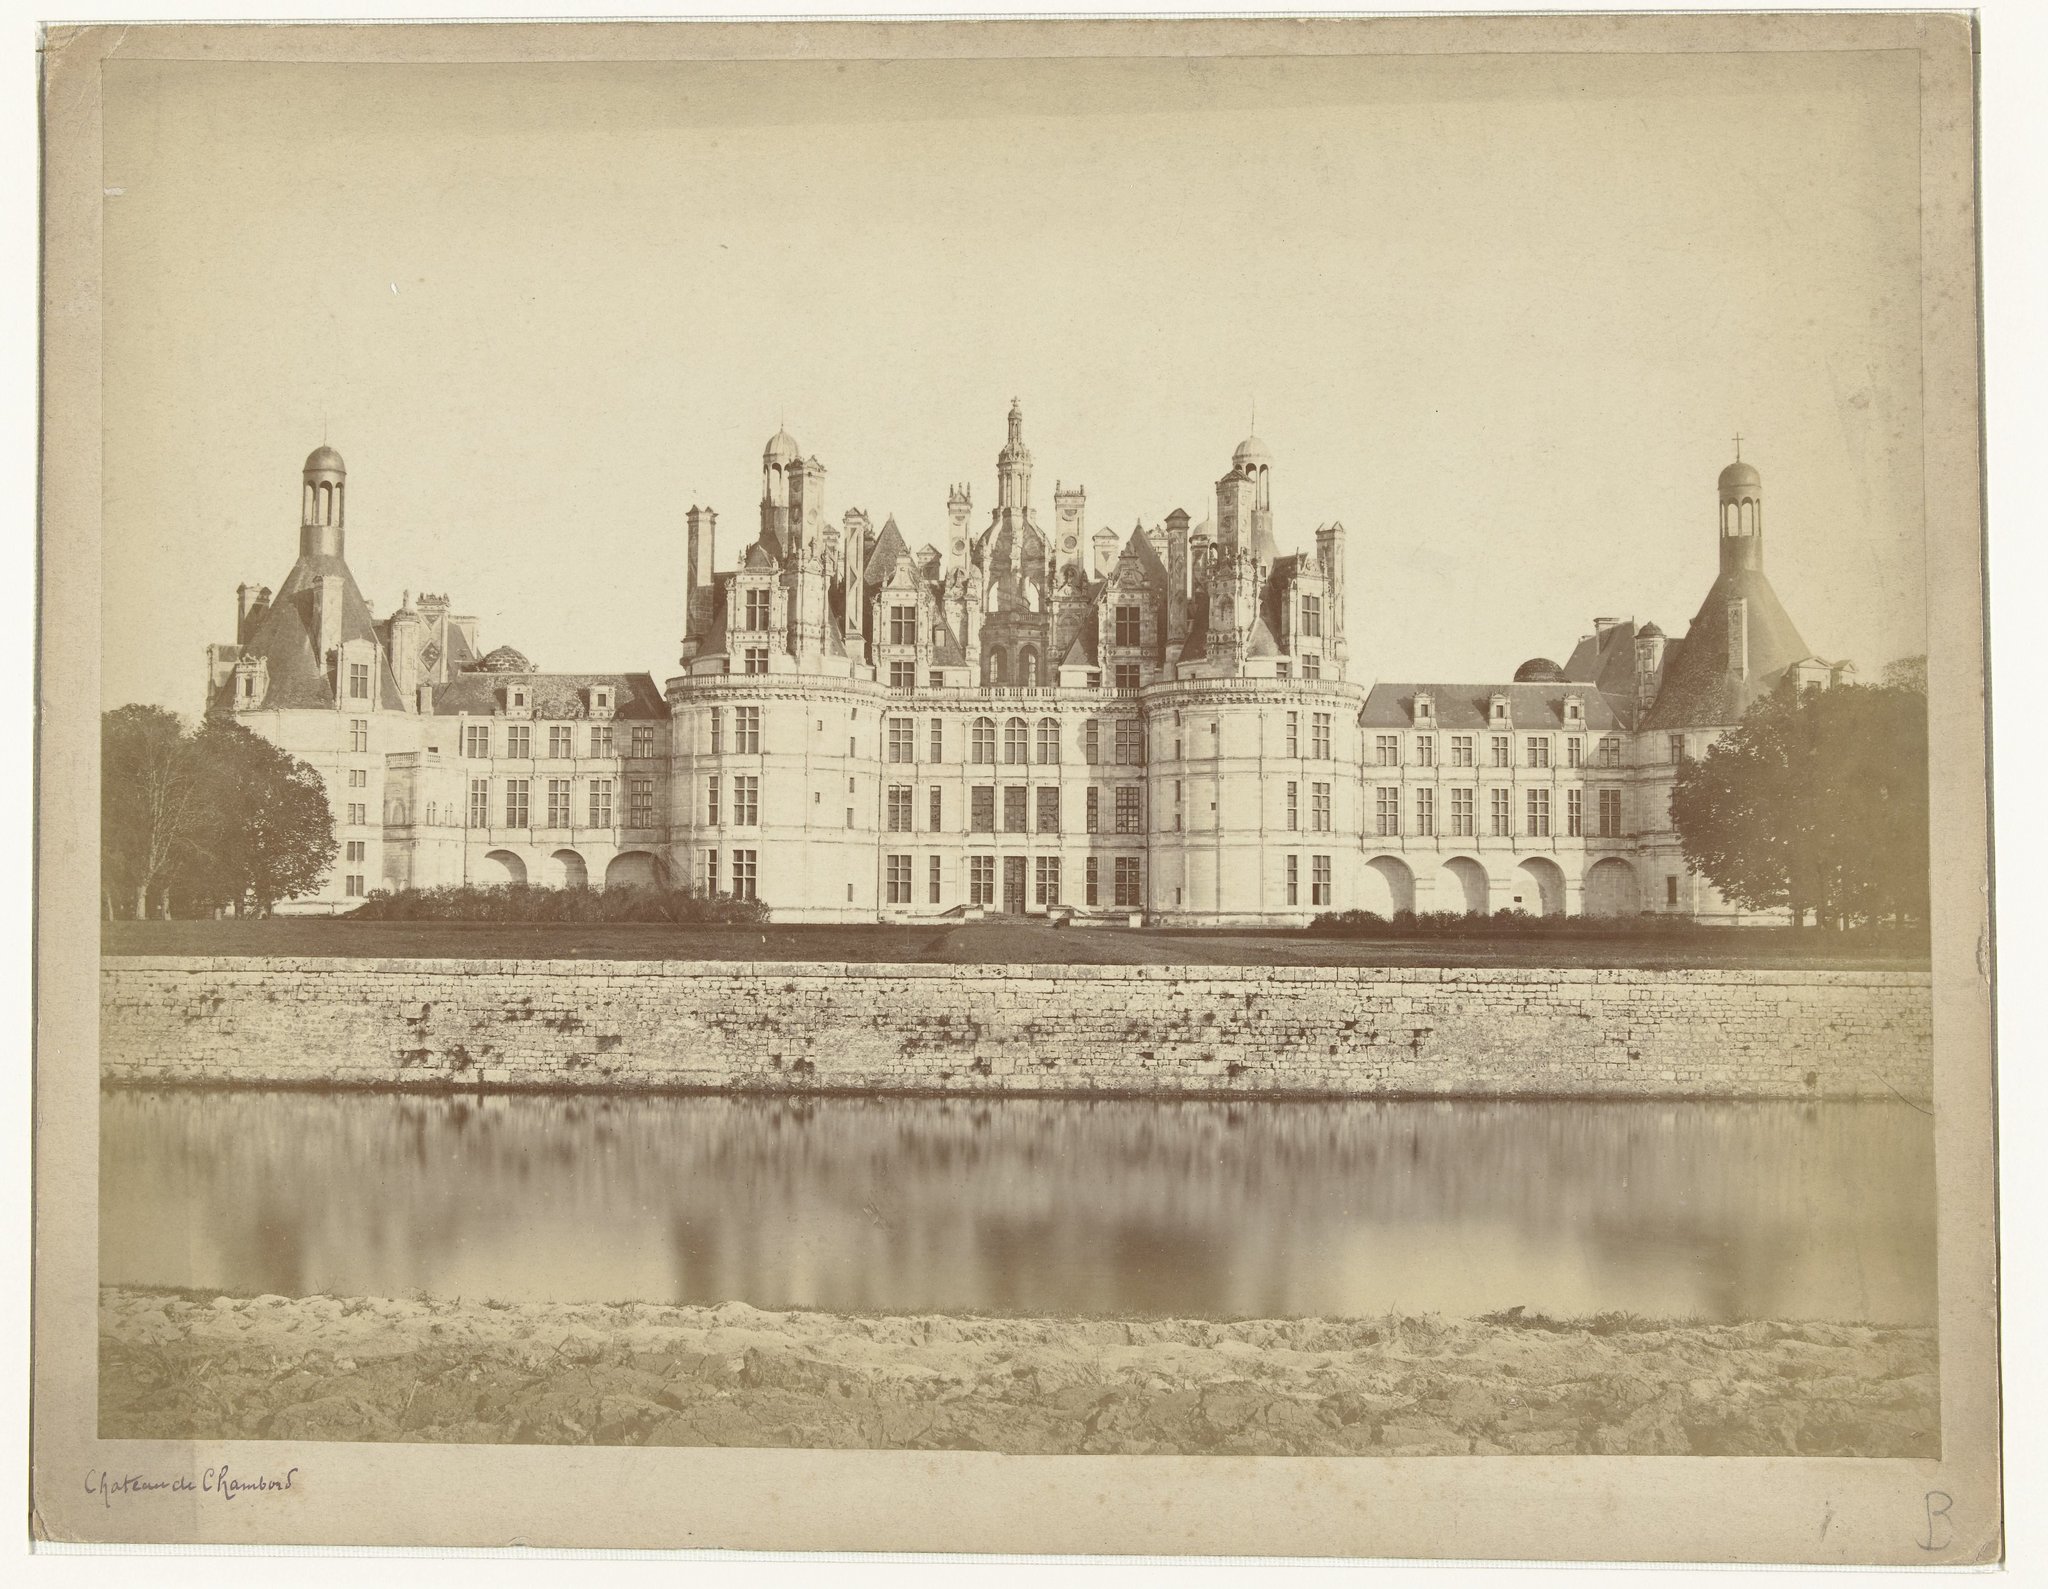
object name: photograph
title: Château de Chambord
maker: Anonymous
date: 1850-1900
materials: cardboard, paper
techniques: albumen print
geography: chambord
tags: castle